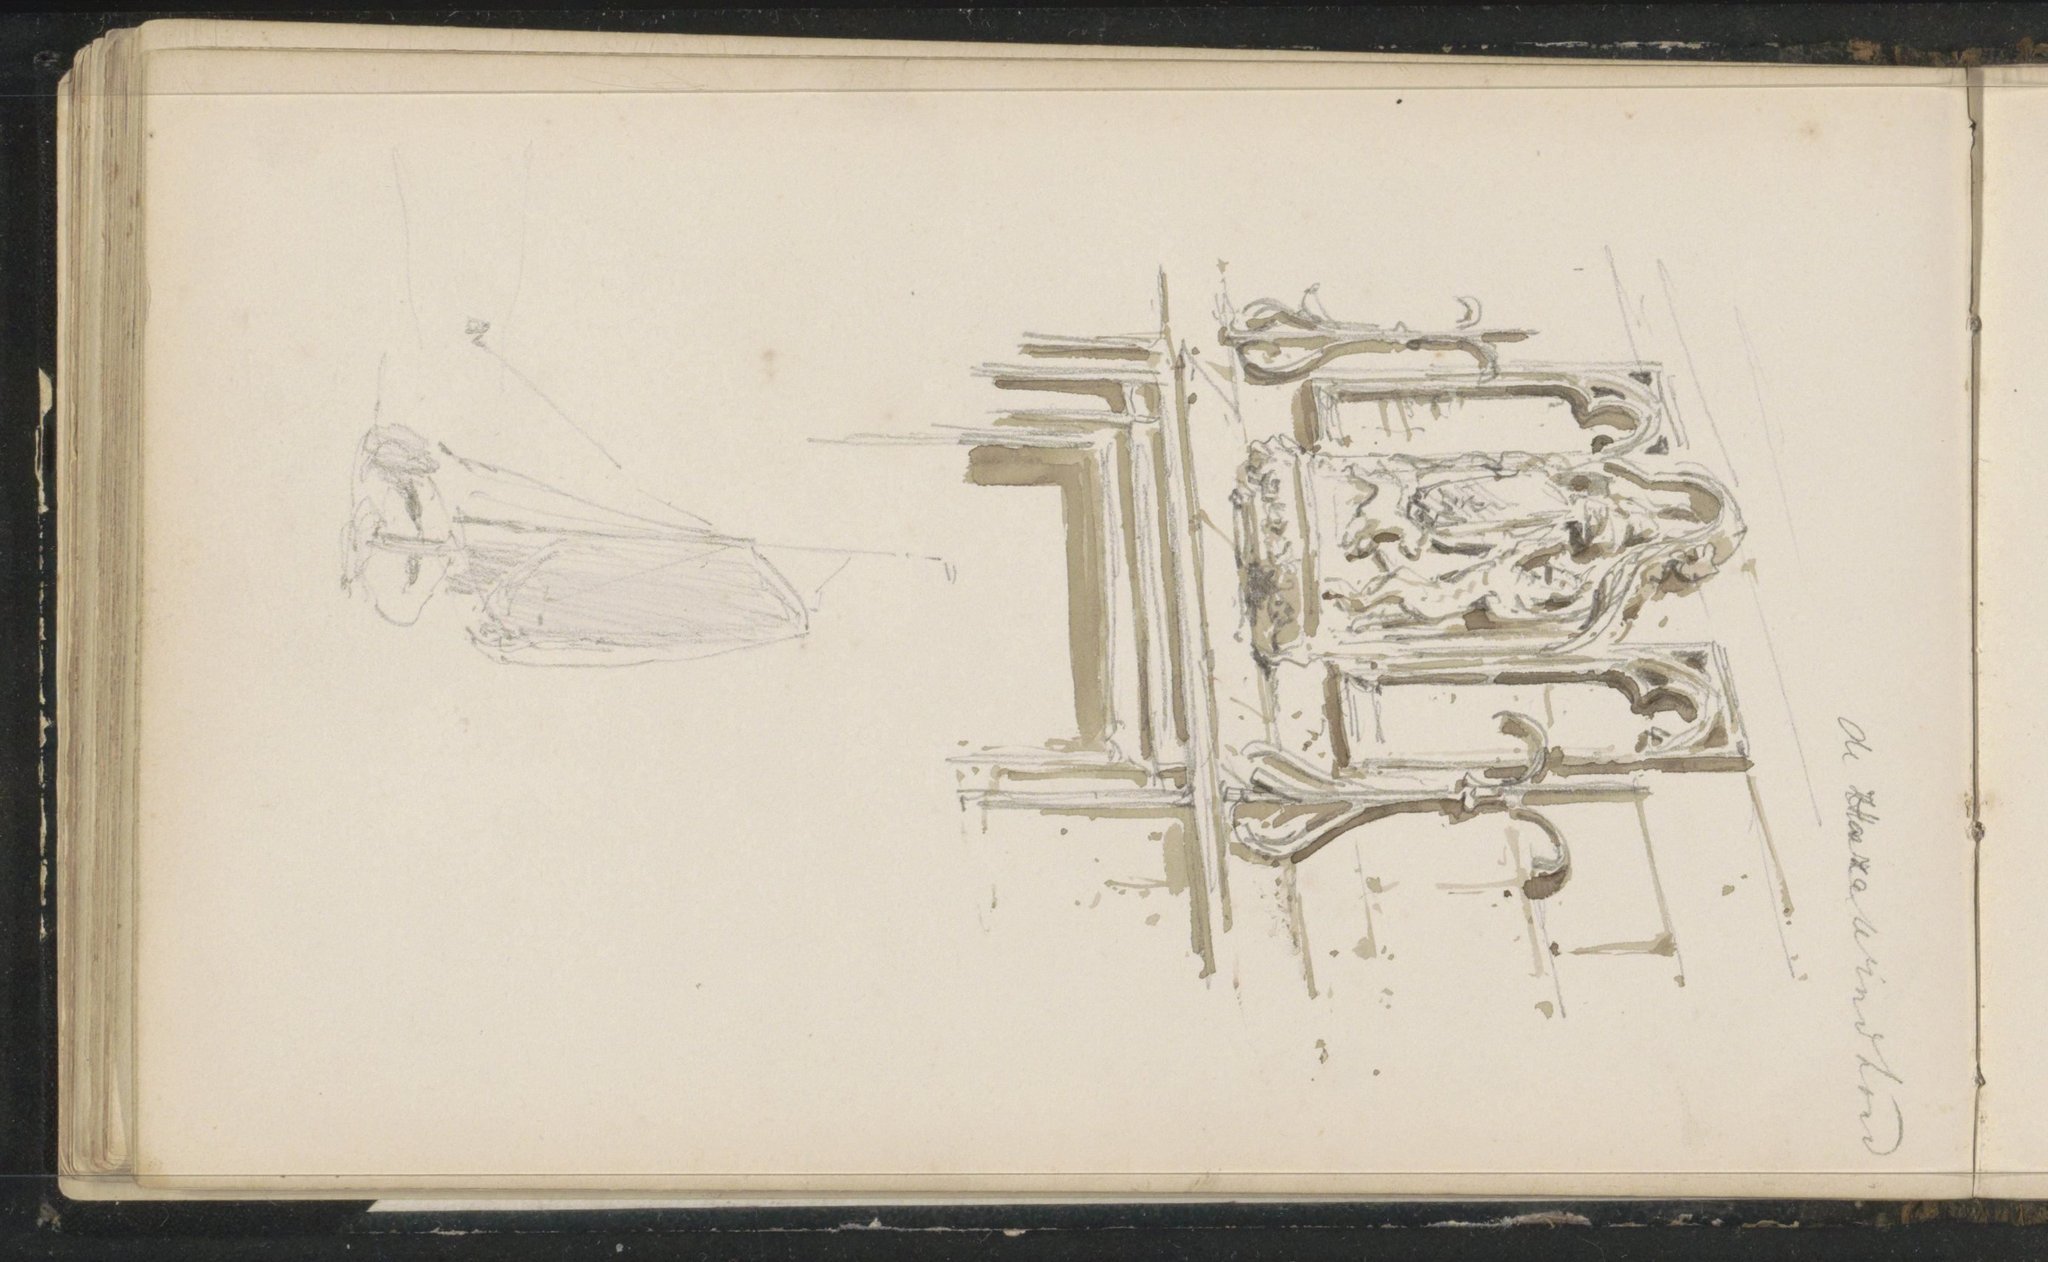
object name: sketchbook leaf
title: Geveldecoratie van 'De Hazewindhond' en een zeilschip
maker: cornelis springer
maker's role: draughtsman, painter, print maker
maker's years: 1817-1891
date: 1857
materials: paper, pencil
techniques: stumping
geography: middelburg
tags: sailing-ship, sailing-boat, decorated gable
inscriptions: annotation: ‘de Hazewindhond’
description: Geveldecoratie van 'De Hazewindhond', het voormalige pand 'De Hazewind' aan de Lange Delft te Middelburg, en een zeilschip. Blad 24 verso uit een schetsboek met 44 bladen vervaardigd in Zeeland en Utrecht.